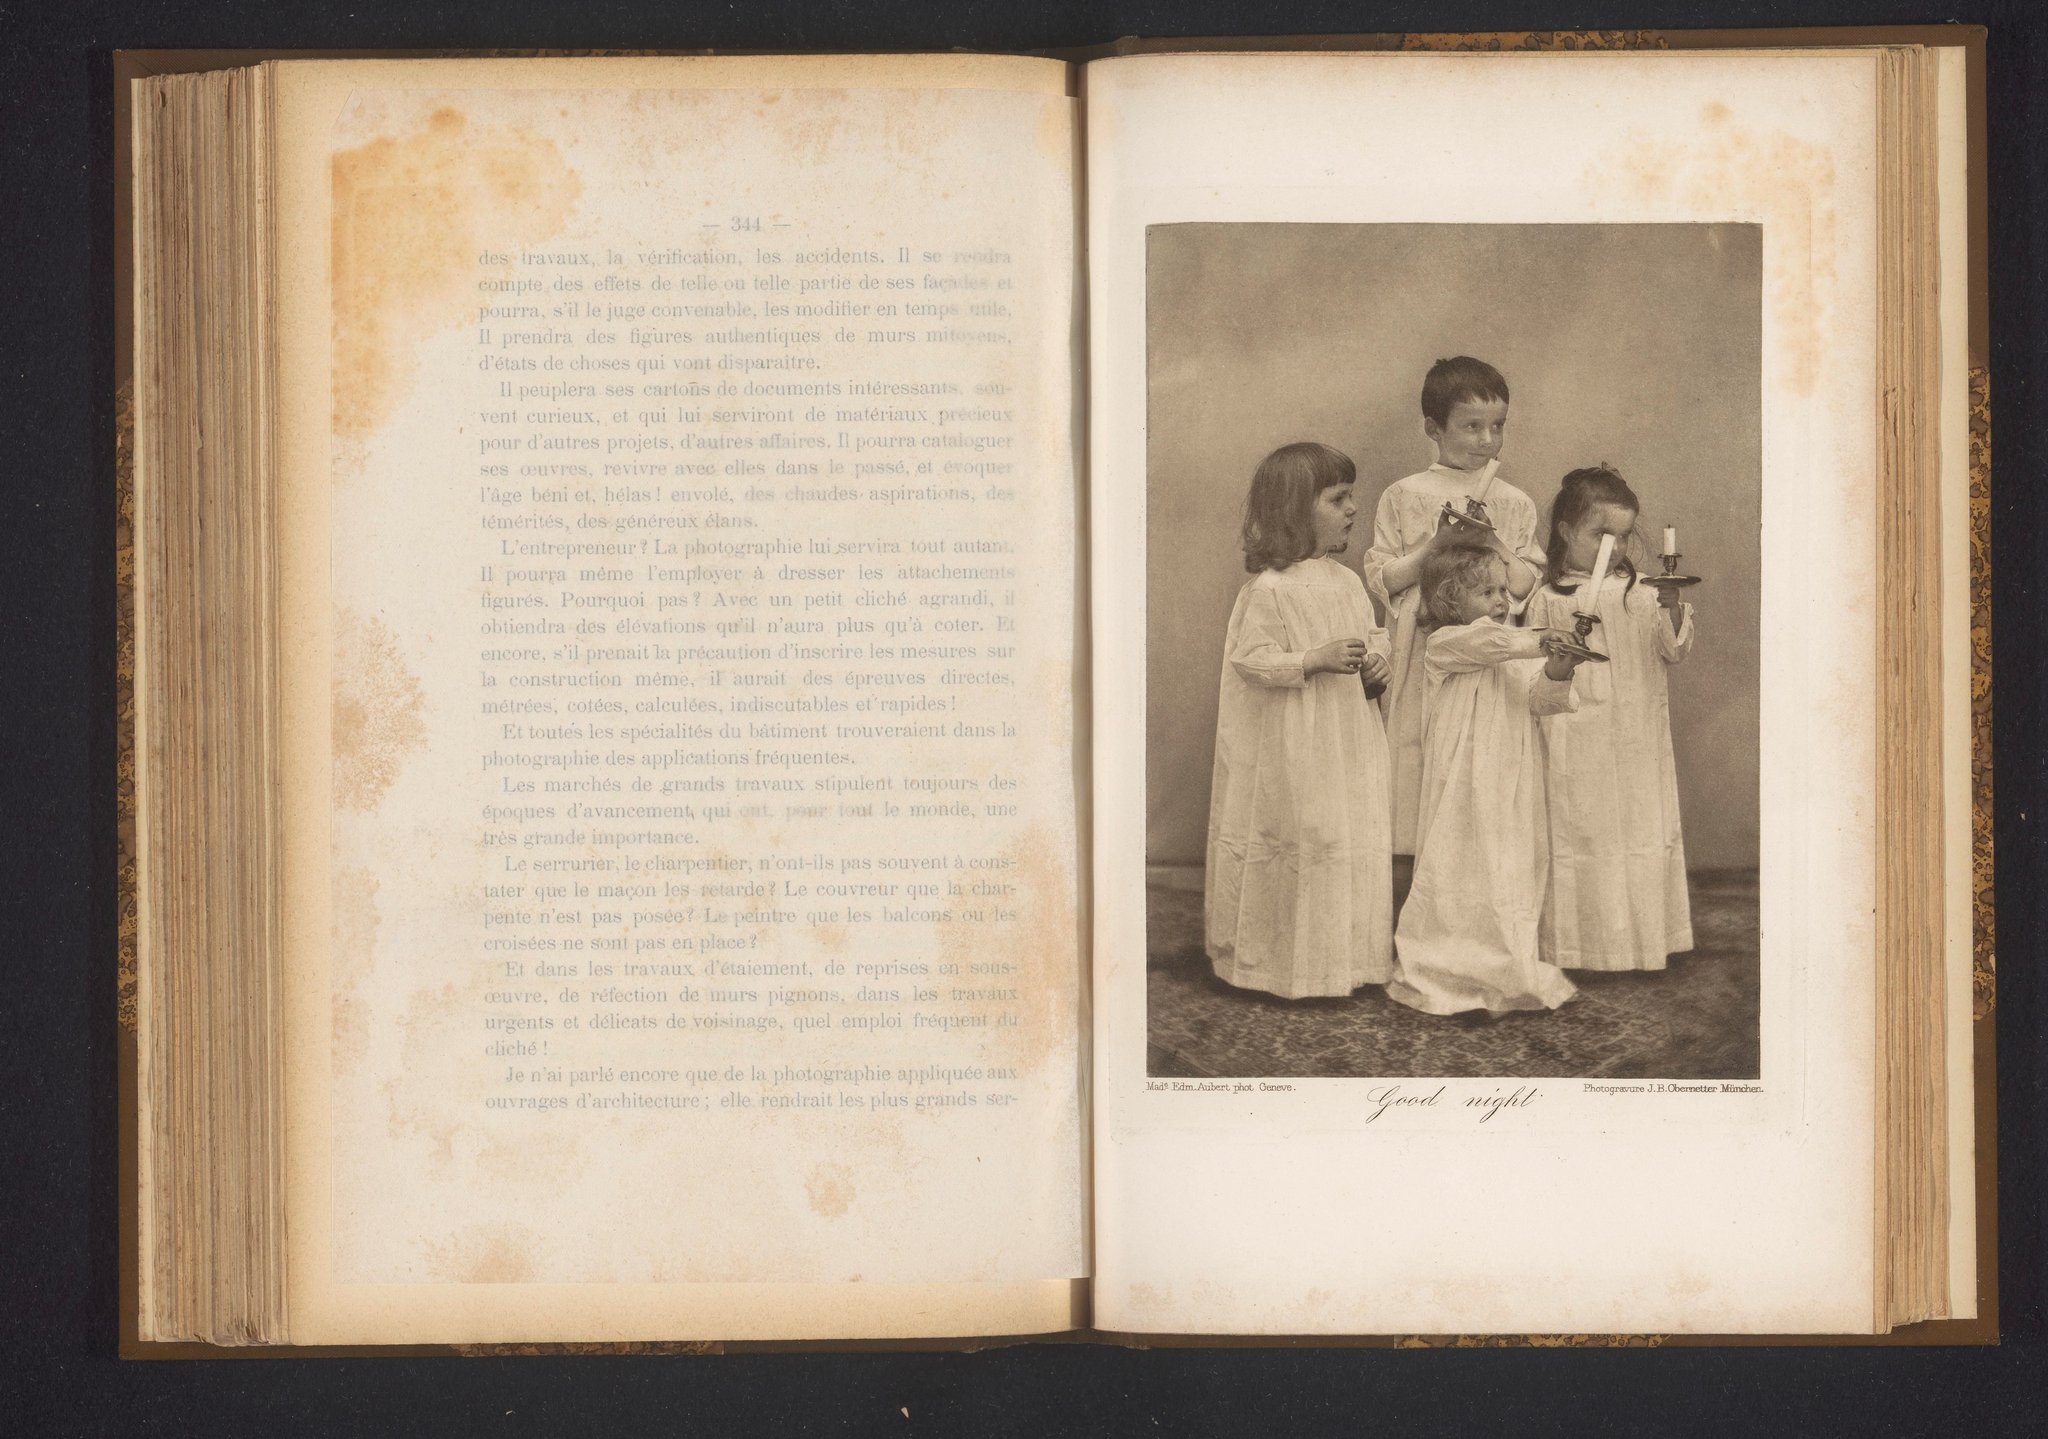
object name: page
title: Good night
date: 1888-1893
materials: paper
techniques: photoaquatint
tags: child, candle